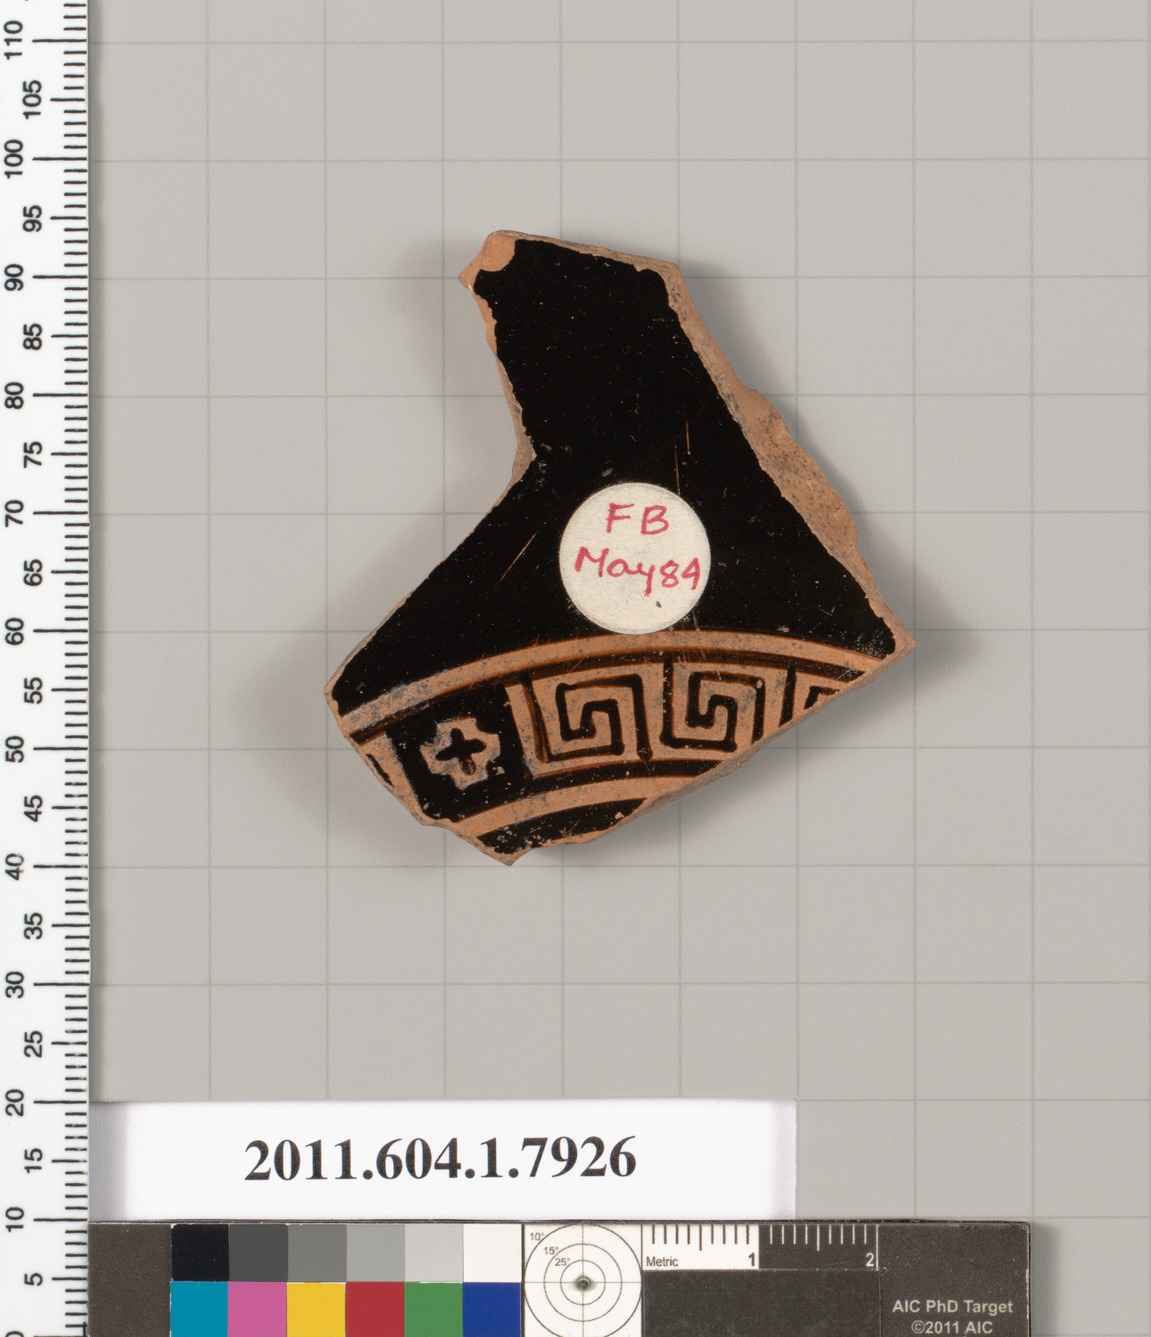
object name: kylix fragment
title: Terracotta fragment of a kylix (drinking cup)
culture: greek, attic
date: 475-451 BCE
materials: terracotta